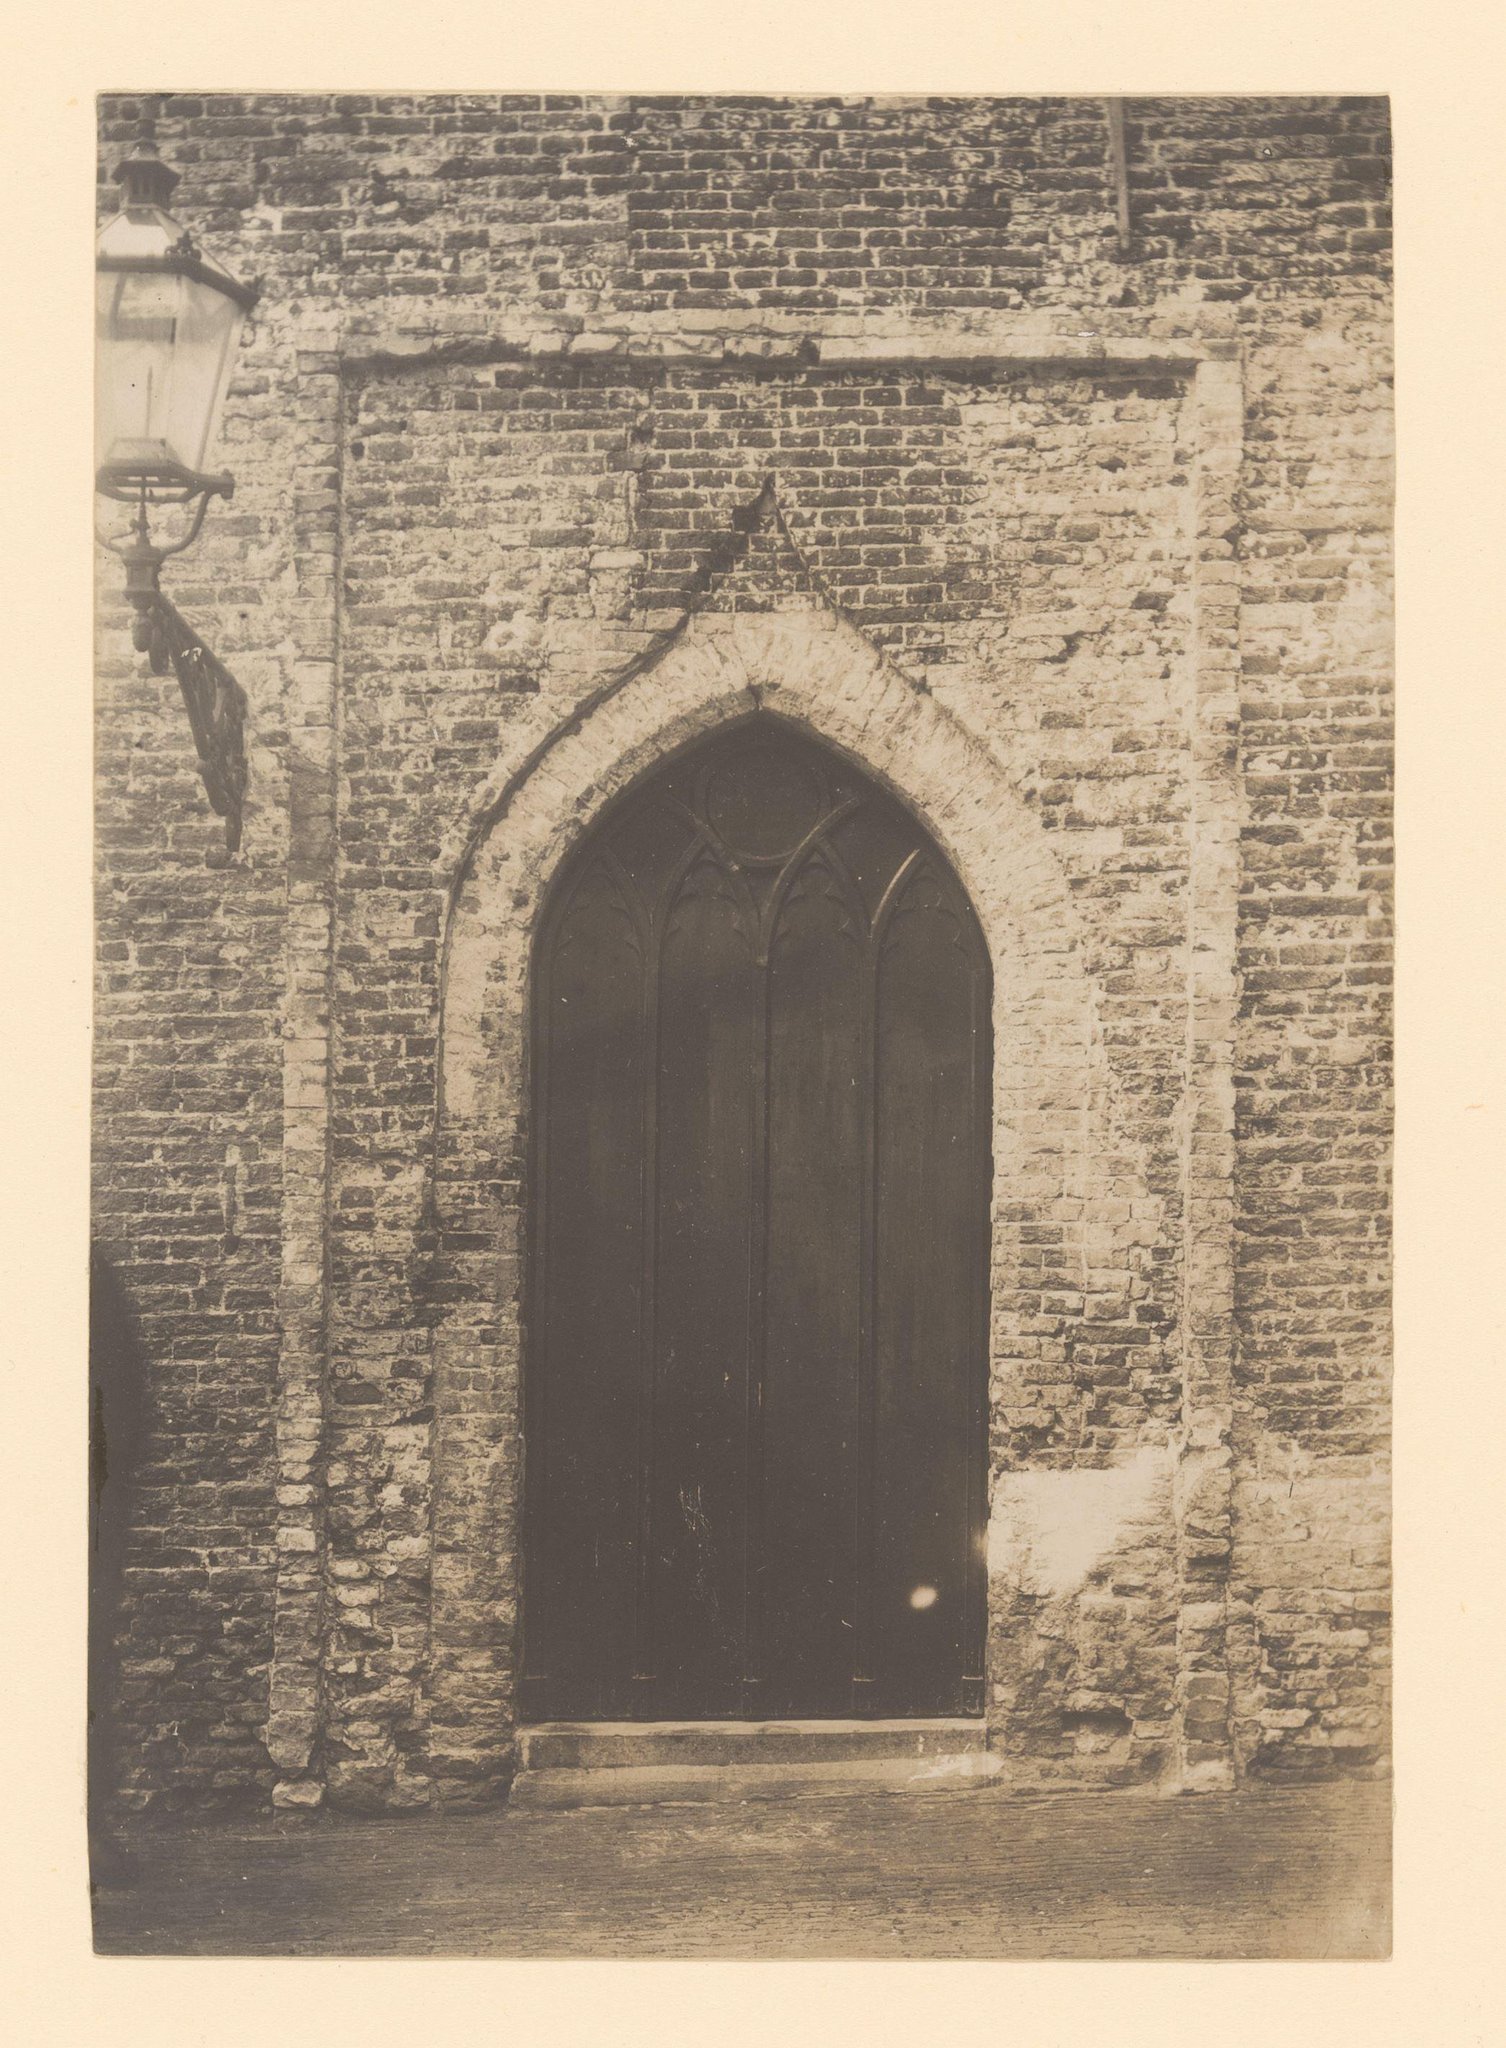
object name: photograph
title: Noordportaal van de Martinikerk te Bolsward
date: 1908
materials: cardboard, photographic support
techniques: gelatin silver print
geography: bolsward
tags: parts of church exterior and annexes: portal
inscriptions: annotation: ‘Bolsward / Noordportaal / Westelijke ingang / Aug 1908’, annotation: ‘Bolsward’